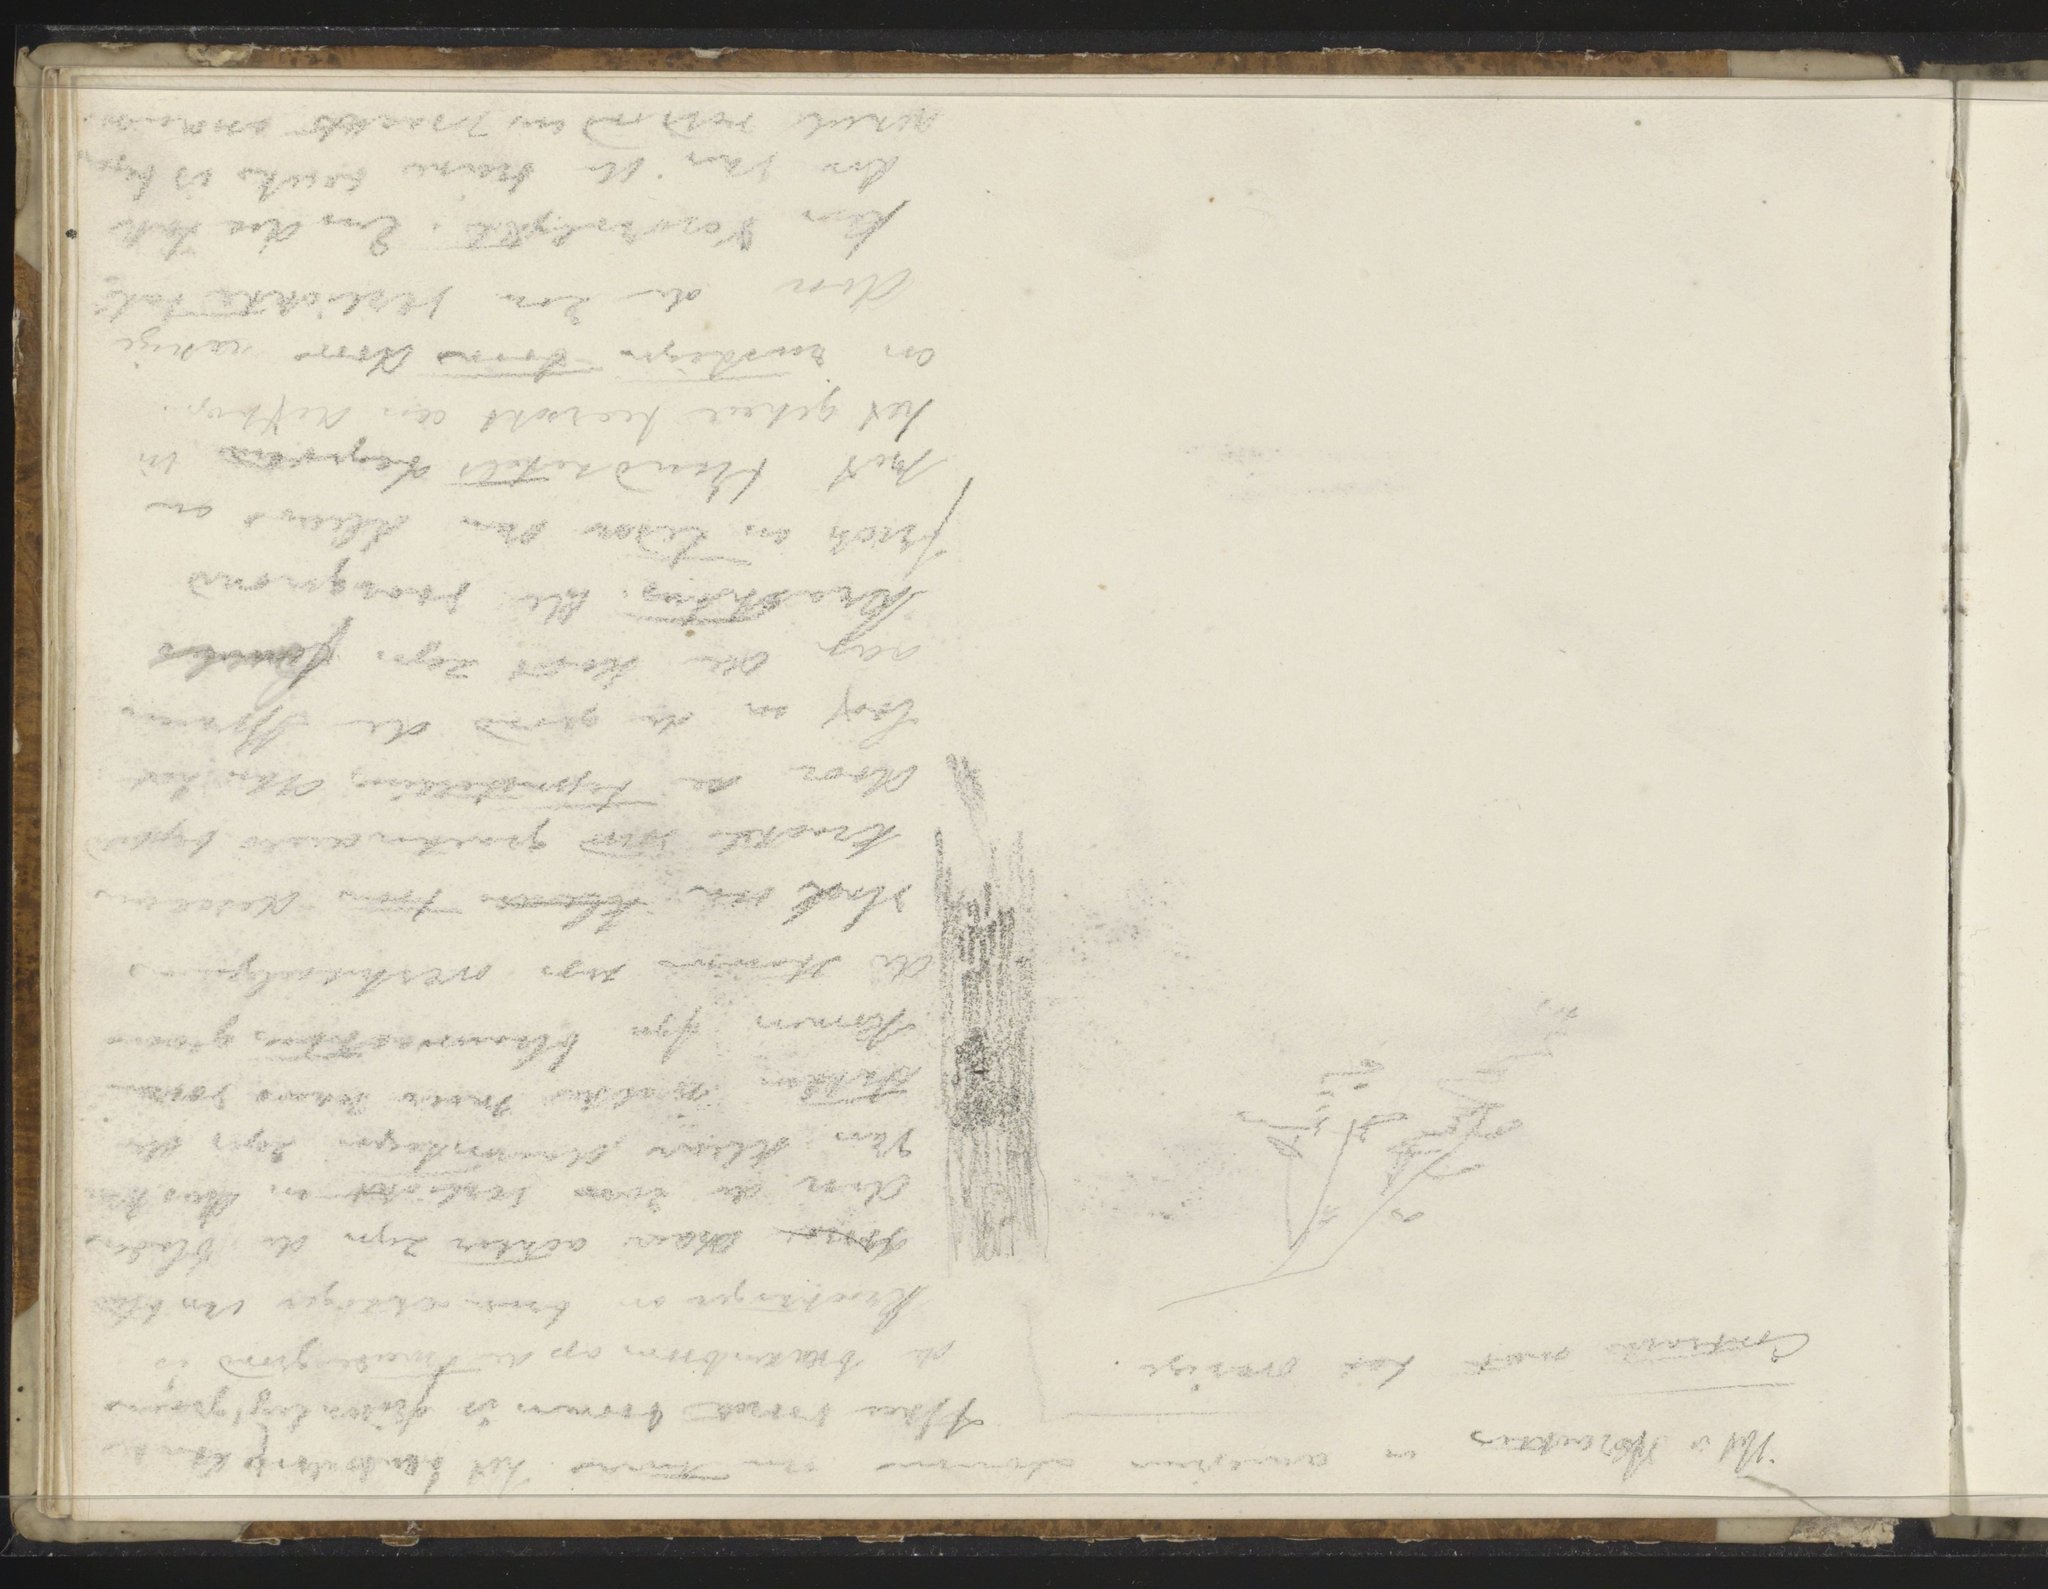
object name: sketchbook leaf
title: Boomstam en plant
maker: maria vos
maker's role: draughtsman, painter, print maker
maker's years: 1824-1906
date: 1834-1906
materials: paper, pencil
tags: plants (in general), trees (+ stem, trunk)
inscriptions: annotation: ‘[...]’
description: Blad 6 verso uit een schetsboek met 39 bladen.